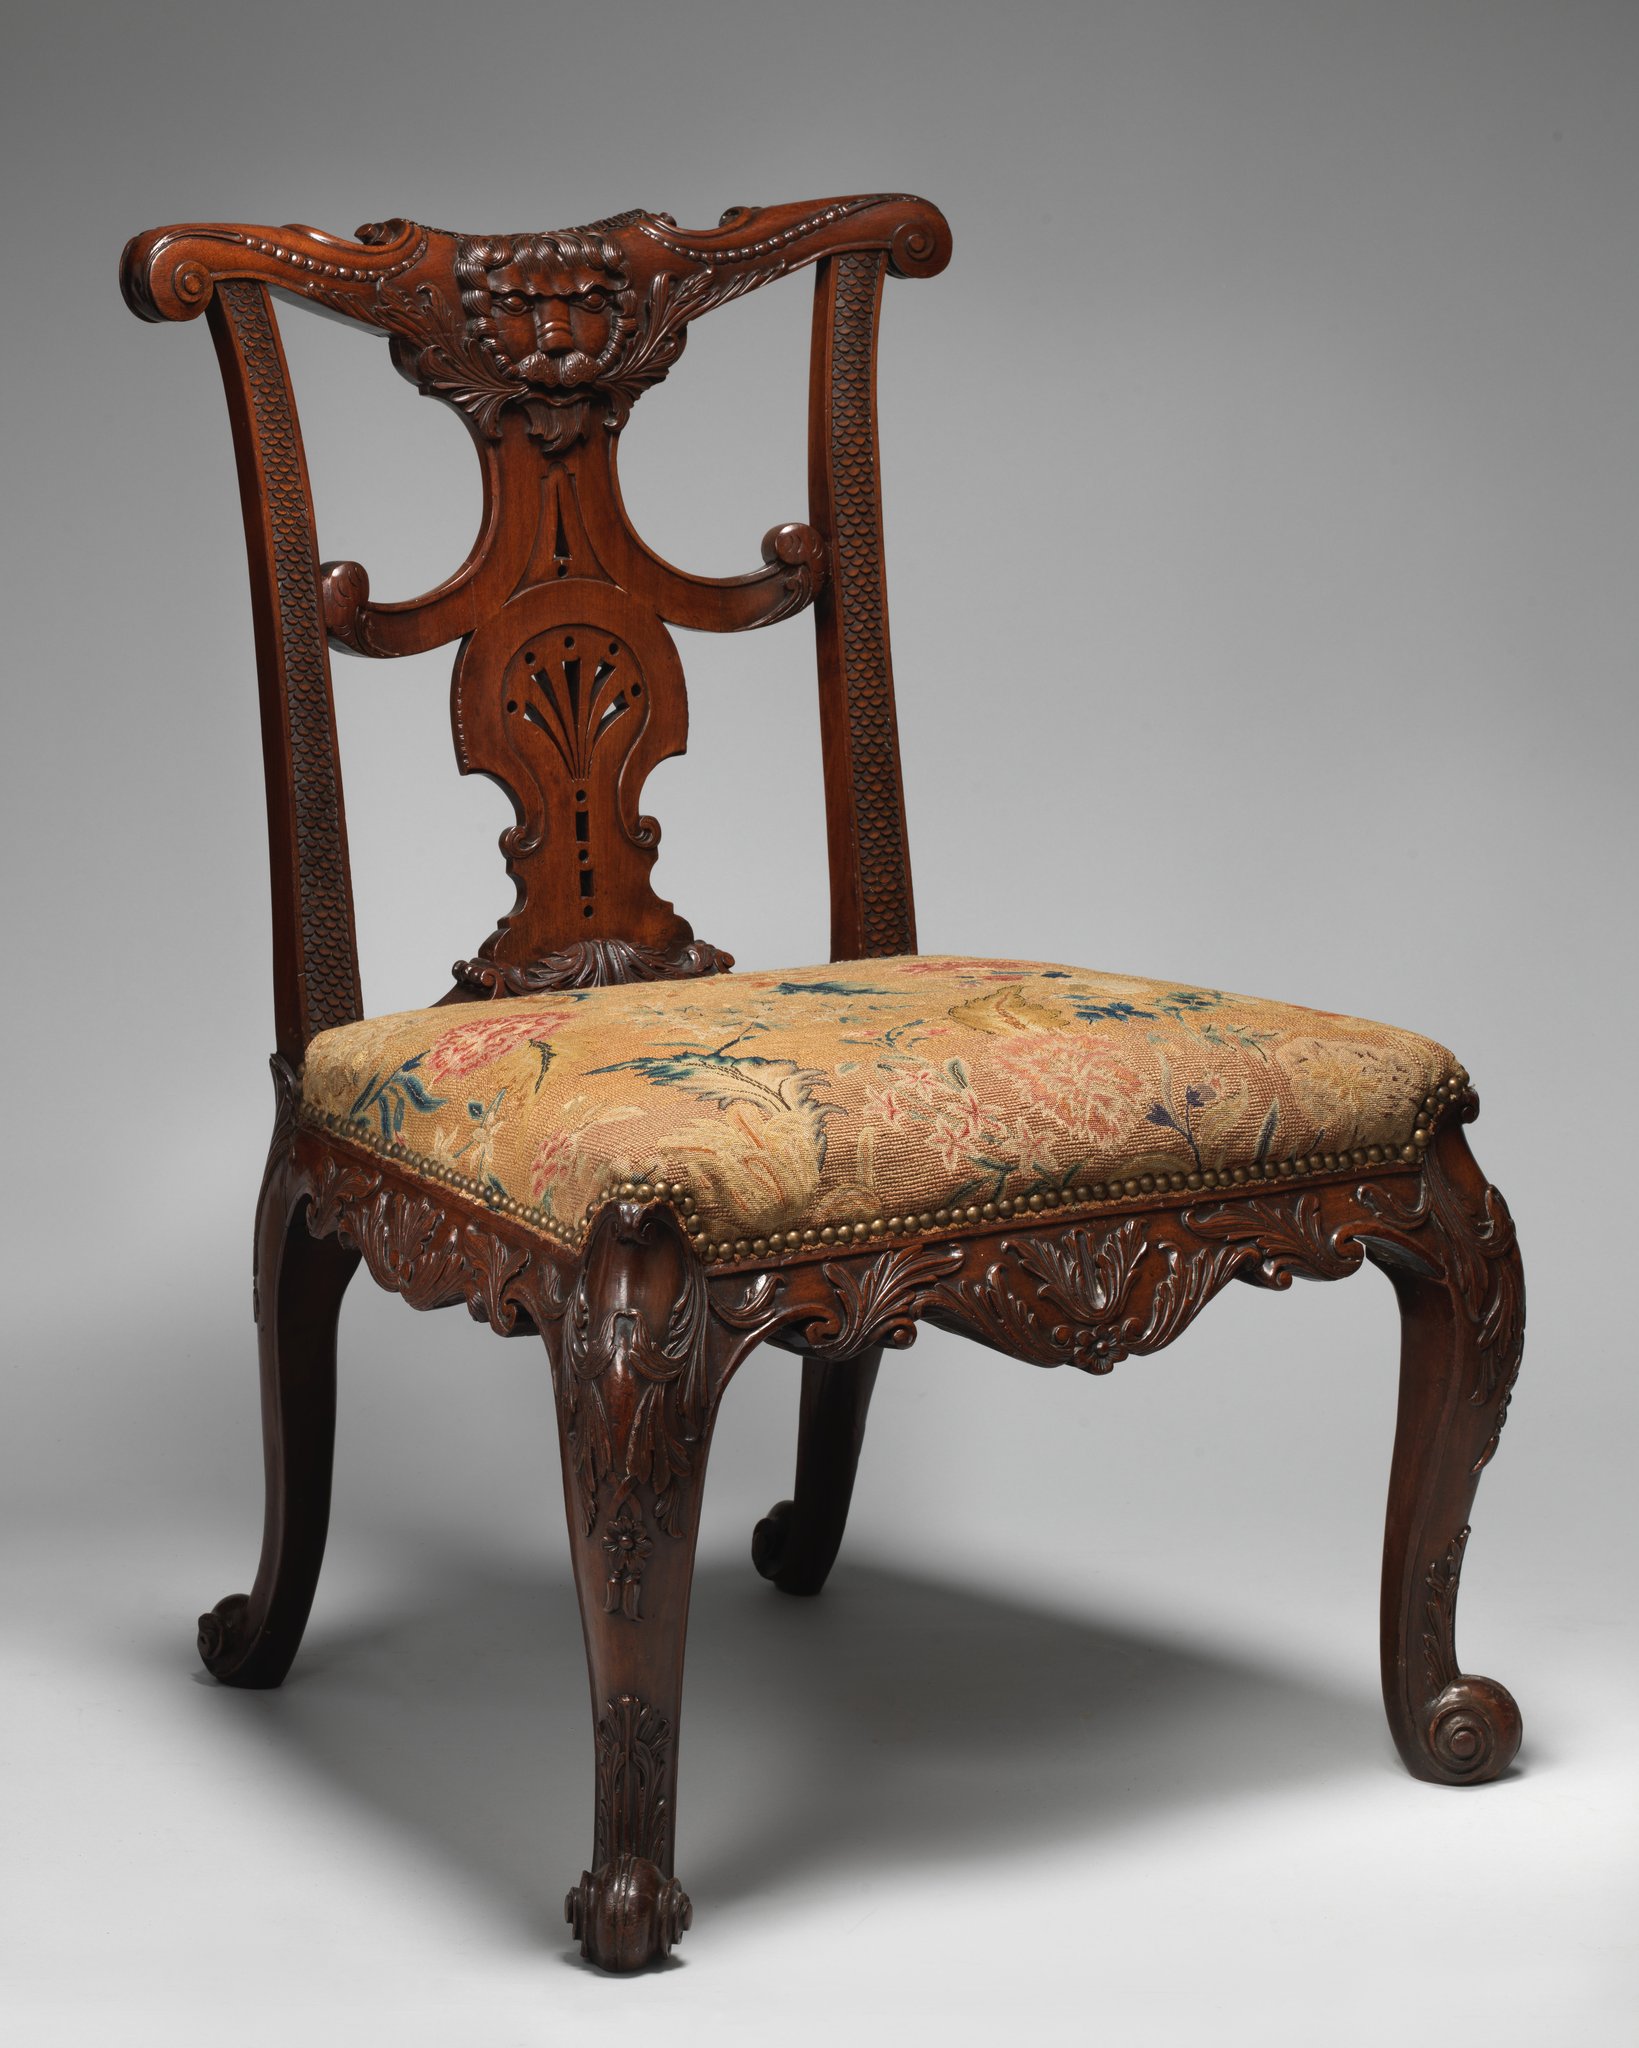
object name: side chair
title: Side chair (one of a pair)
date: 1735-1740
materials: wood